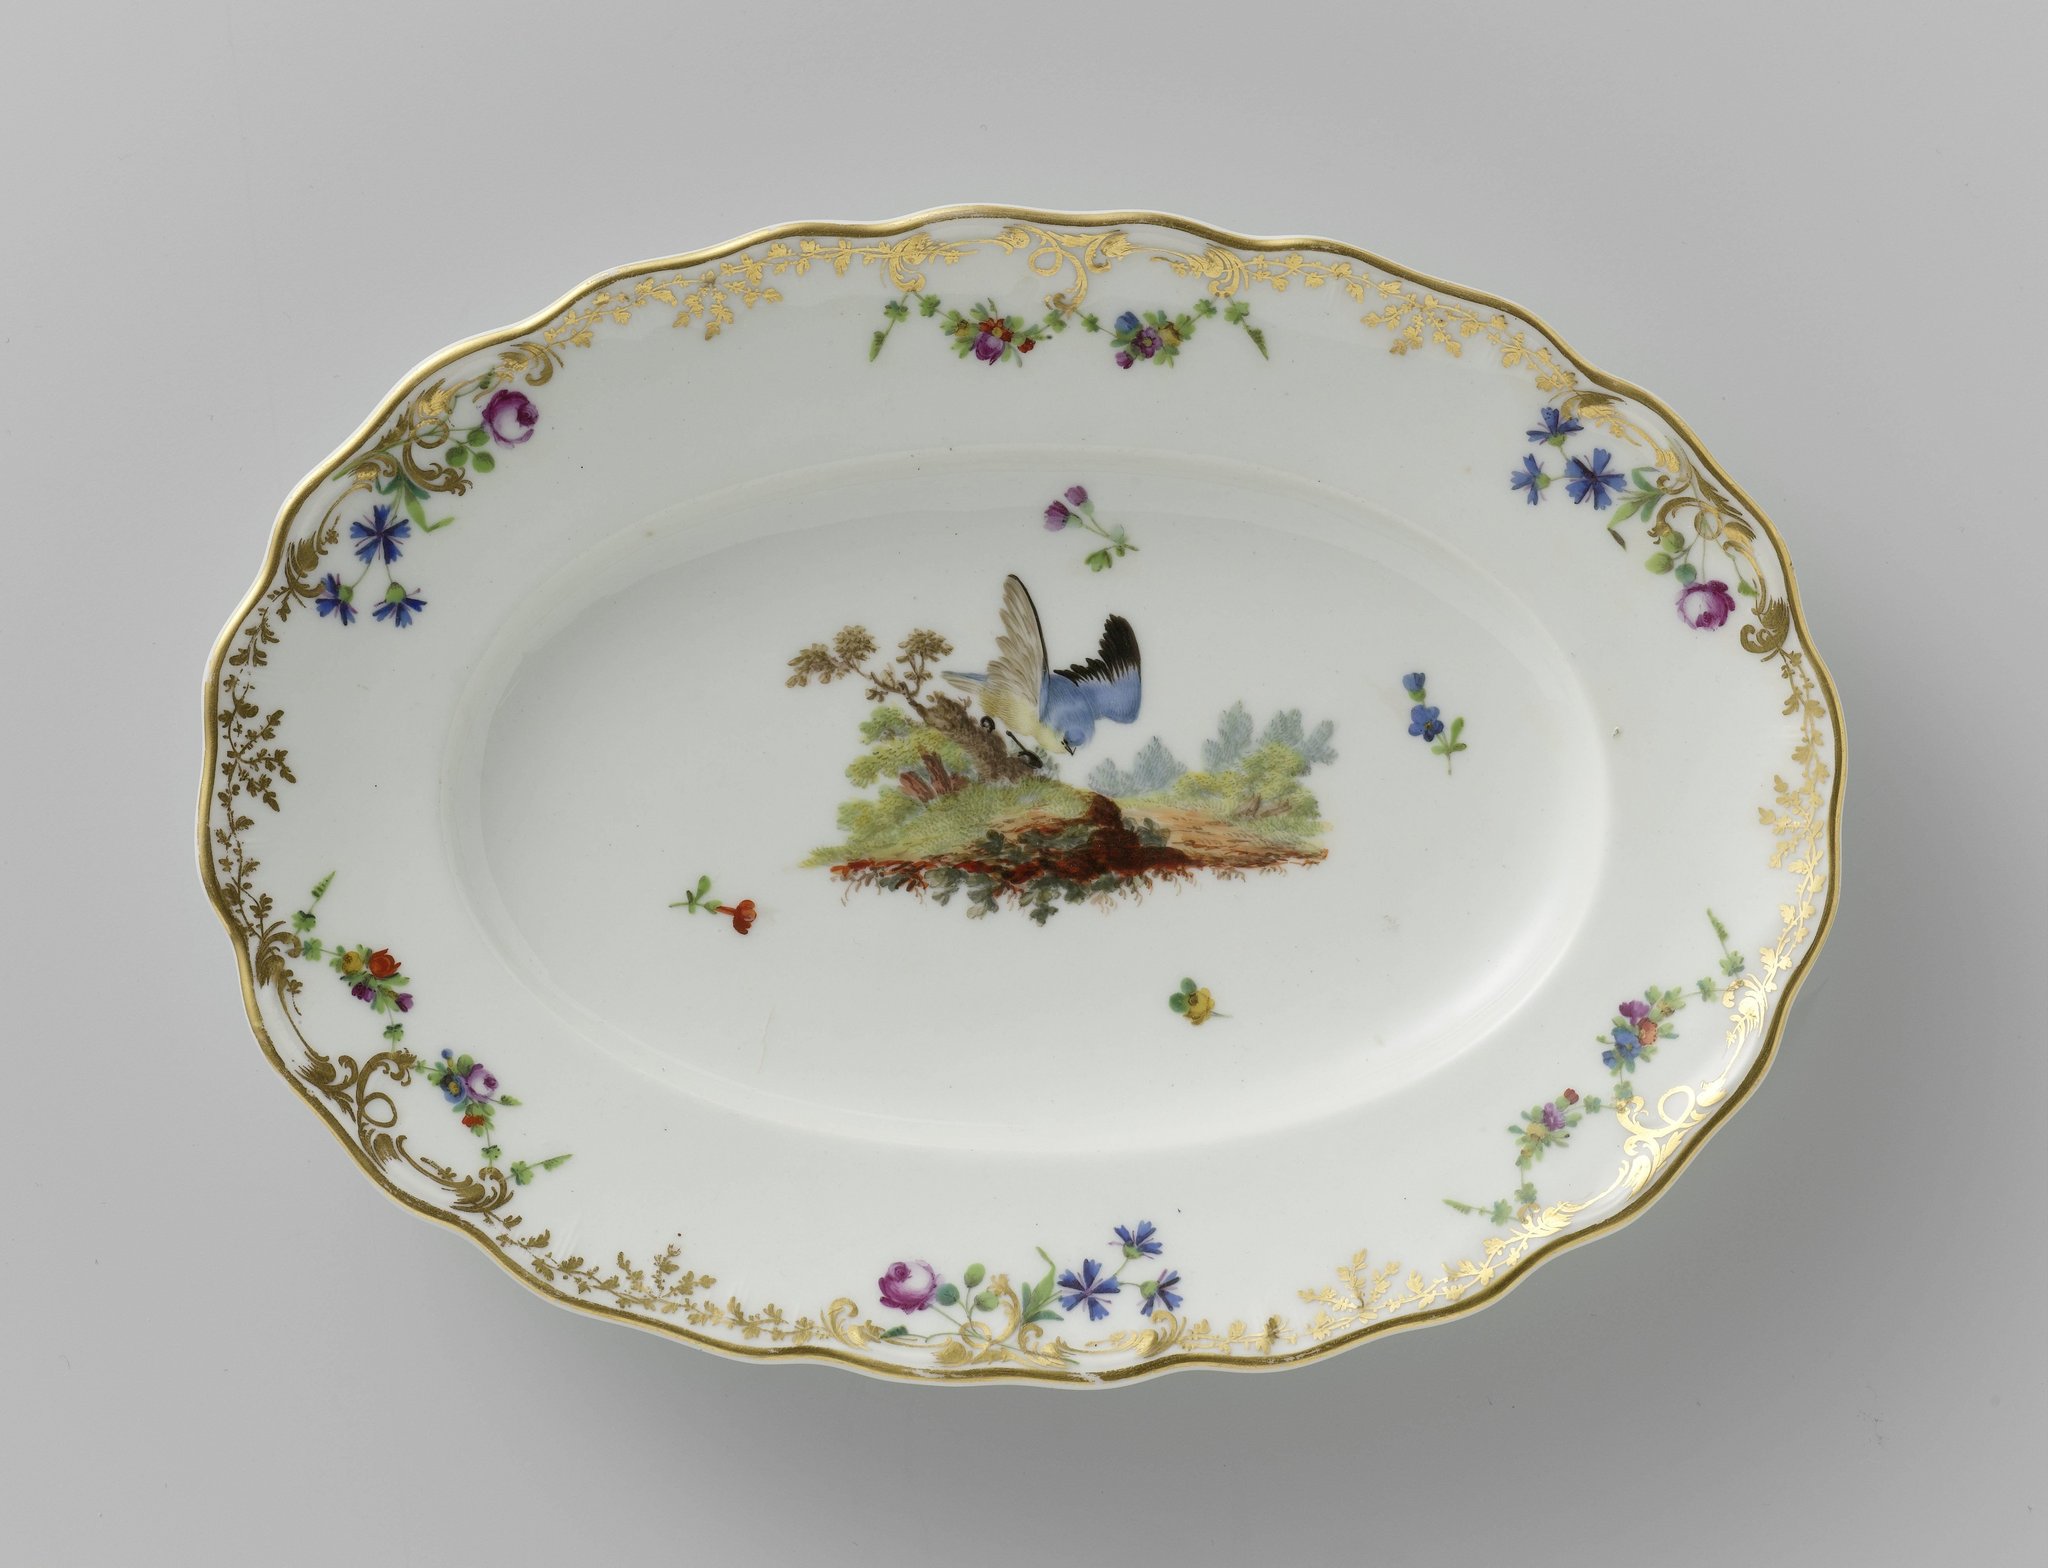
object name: amstel porselein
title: Onderschotel van porselein, veelkleurig beschilderd met vogels in een landschap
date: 1784-1809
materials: porcelain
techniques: painted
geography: ouder-amstel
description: Onderschotel van porselein, veelkleurig beschilderd met vogels in een landschap. Langs de randen rocailles in relief, waaroverheen bladslingers en C-voluten in goud. Gemerkt: Amstel in onderglazuurblauw en ingegrift in L 1(of 3) met ster.